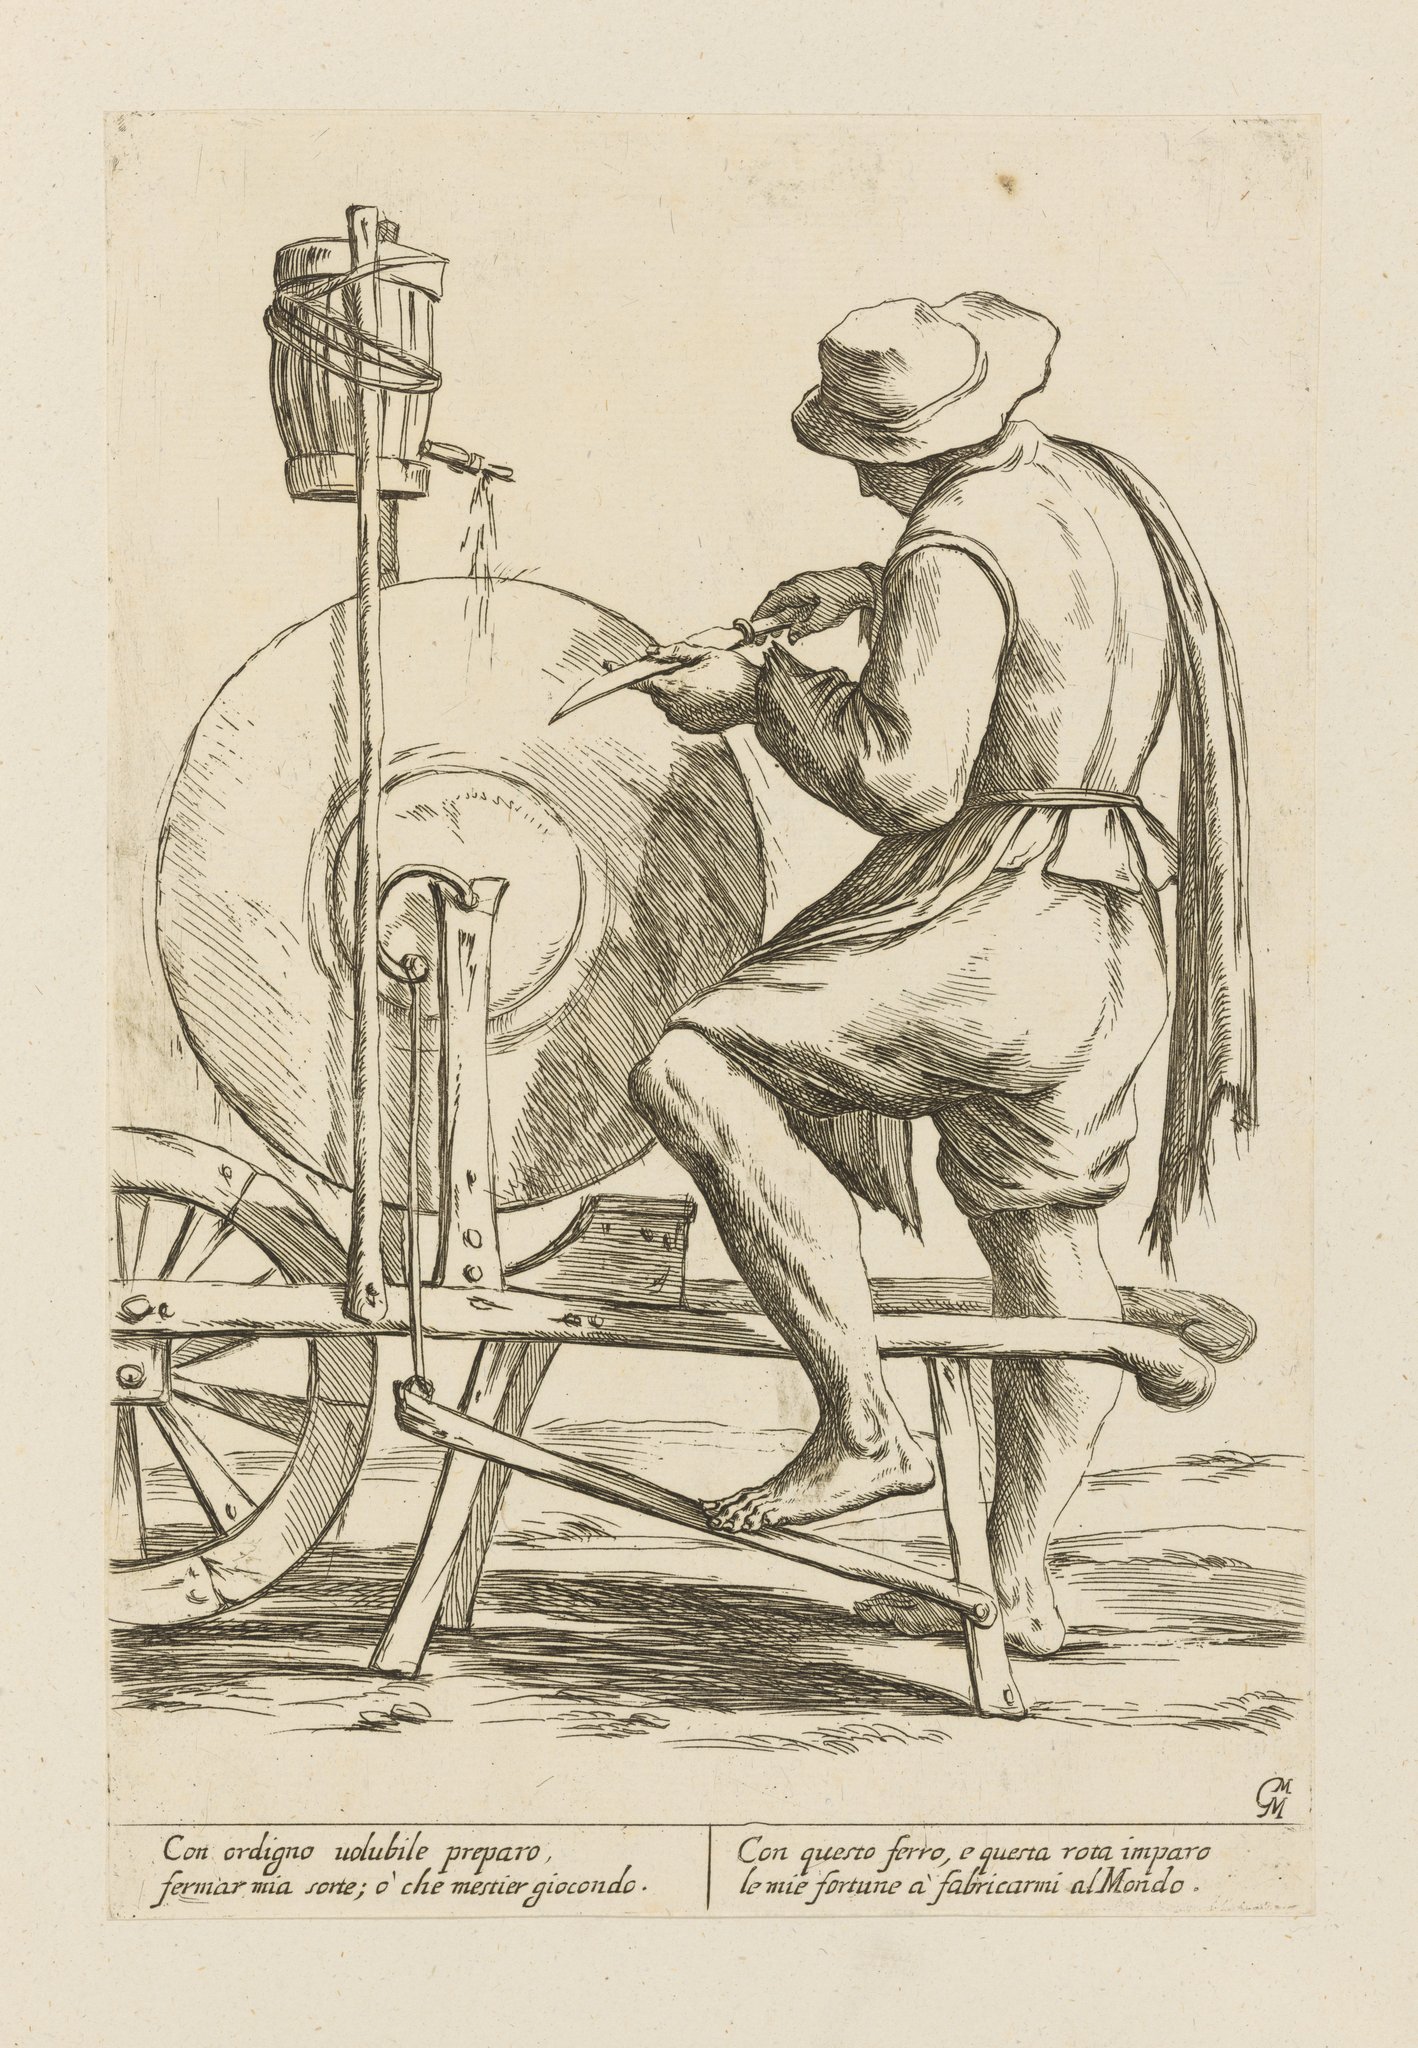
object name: print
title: Knife Grinder, from Di Bologna l'Arti per via D'An.ibal' Ca.rac, plate 40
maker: giuseppe maria mitelli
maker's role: artist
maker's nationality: italian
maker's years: 1634-1718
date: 1660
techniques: etching